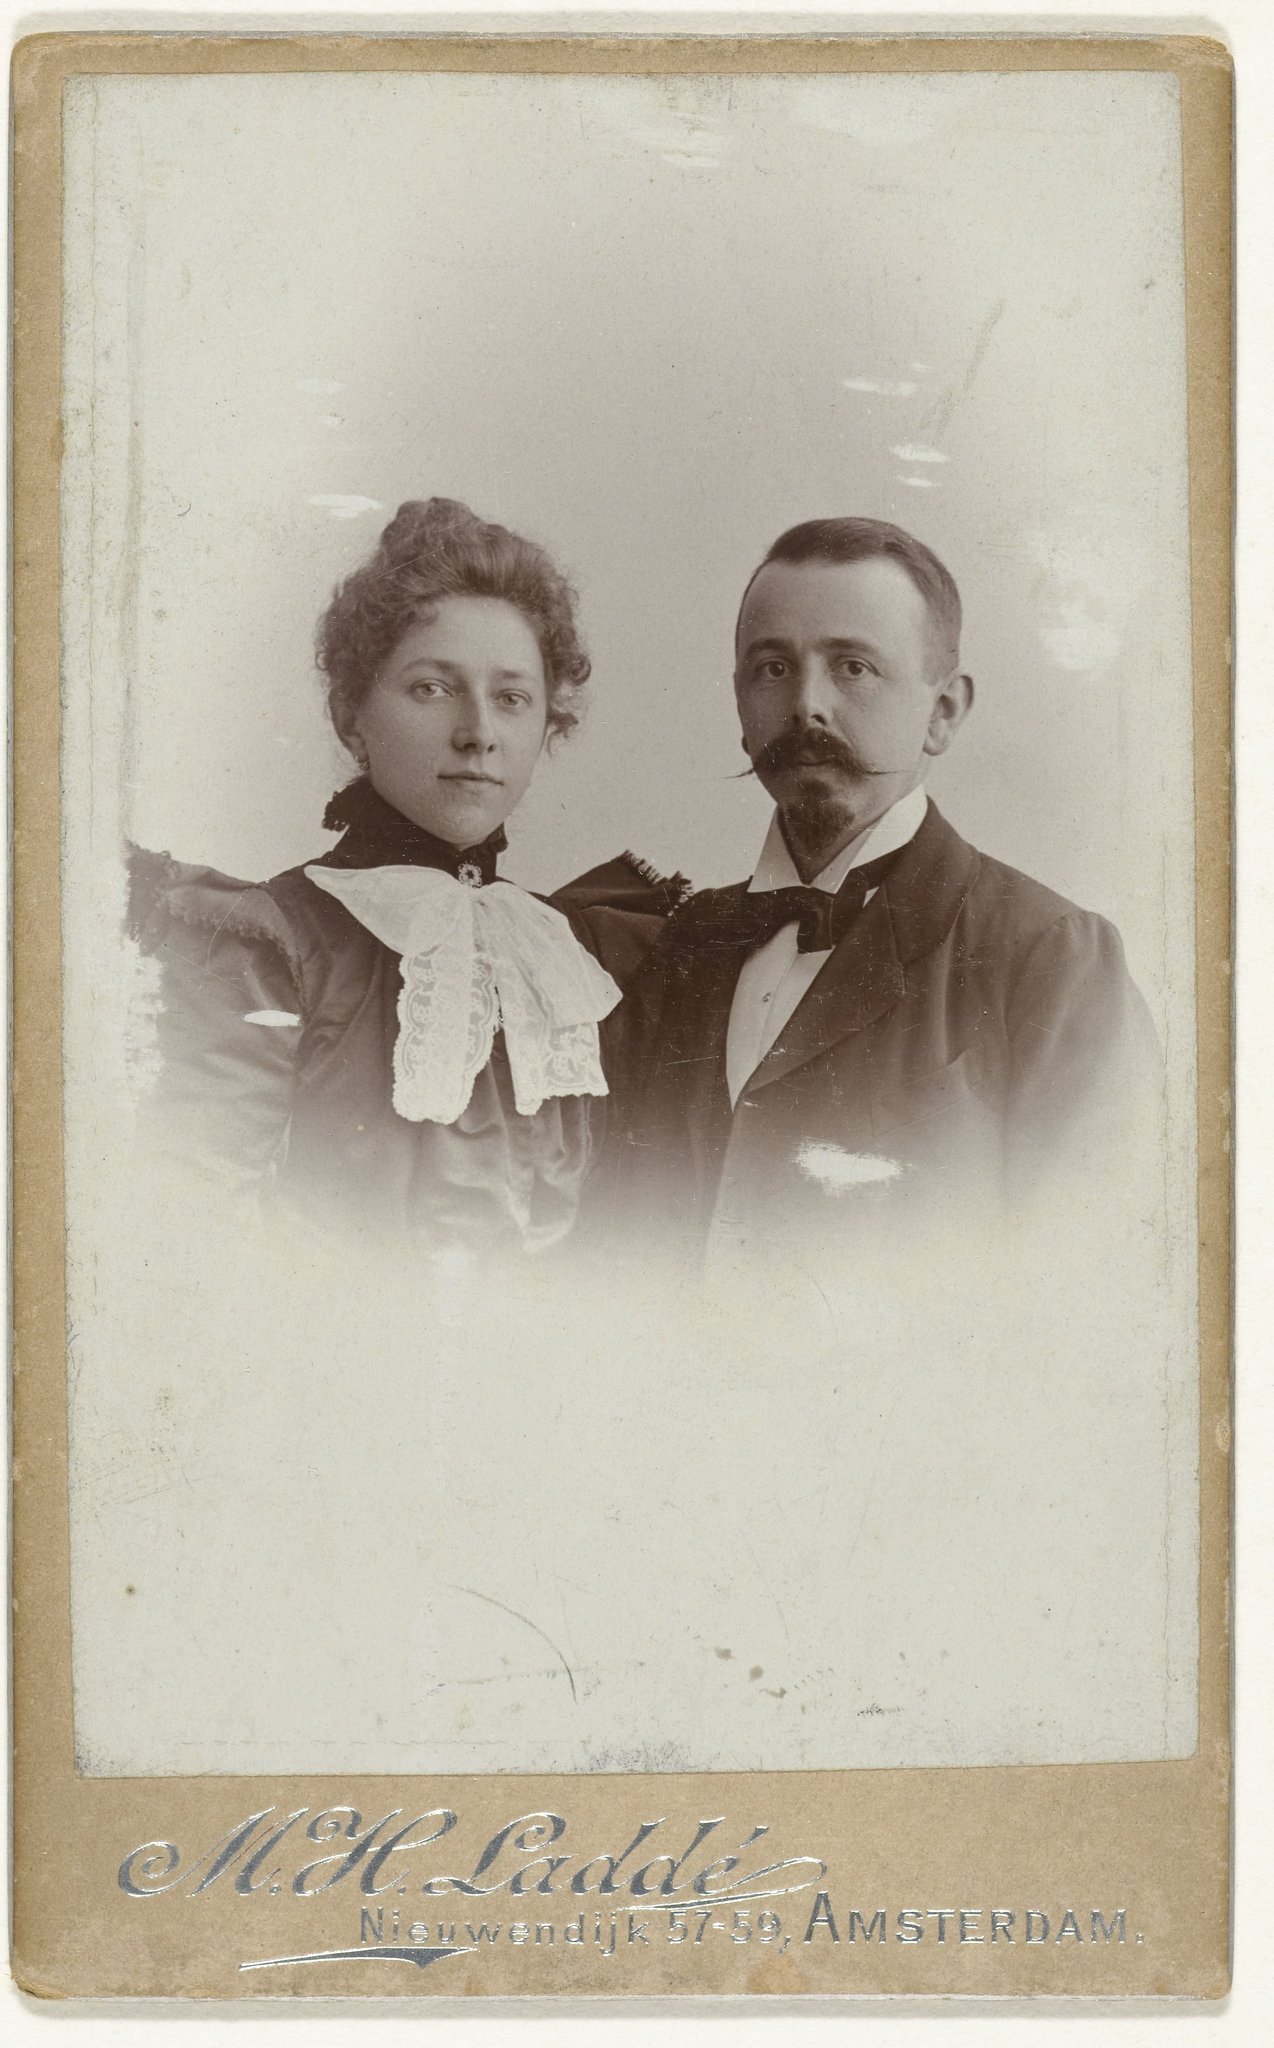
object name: photograph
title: W.C. van der Kop en W.G. Hoogendijk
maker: machiel hendricus laddé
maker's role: fotograaf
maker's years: 1866-1932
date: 1890-1920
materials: cardboard, paper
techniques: collodion silver print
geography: amsterdam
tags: willem carel van der kop, historical persons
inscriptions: annotation: ‘W.C. van der Kop en W.G. Hoogendijk’